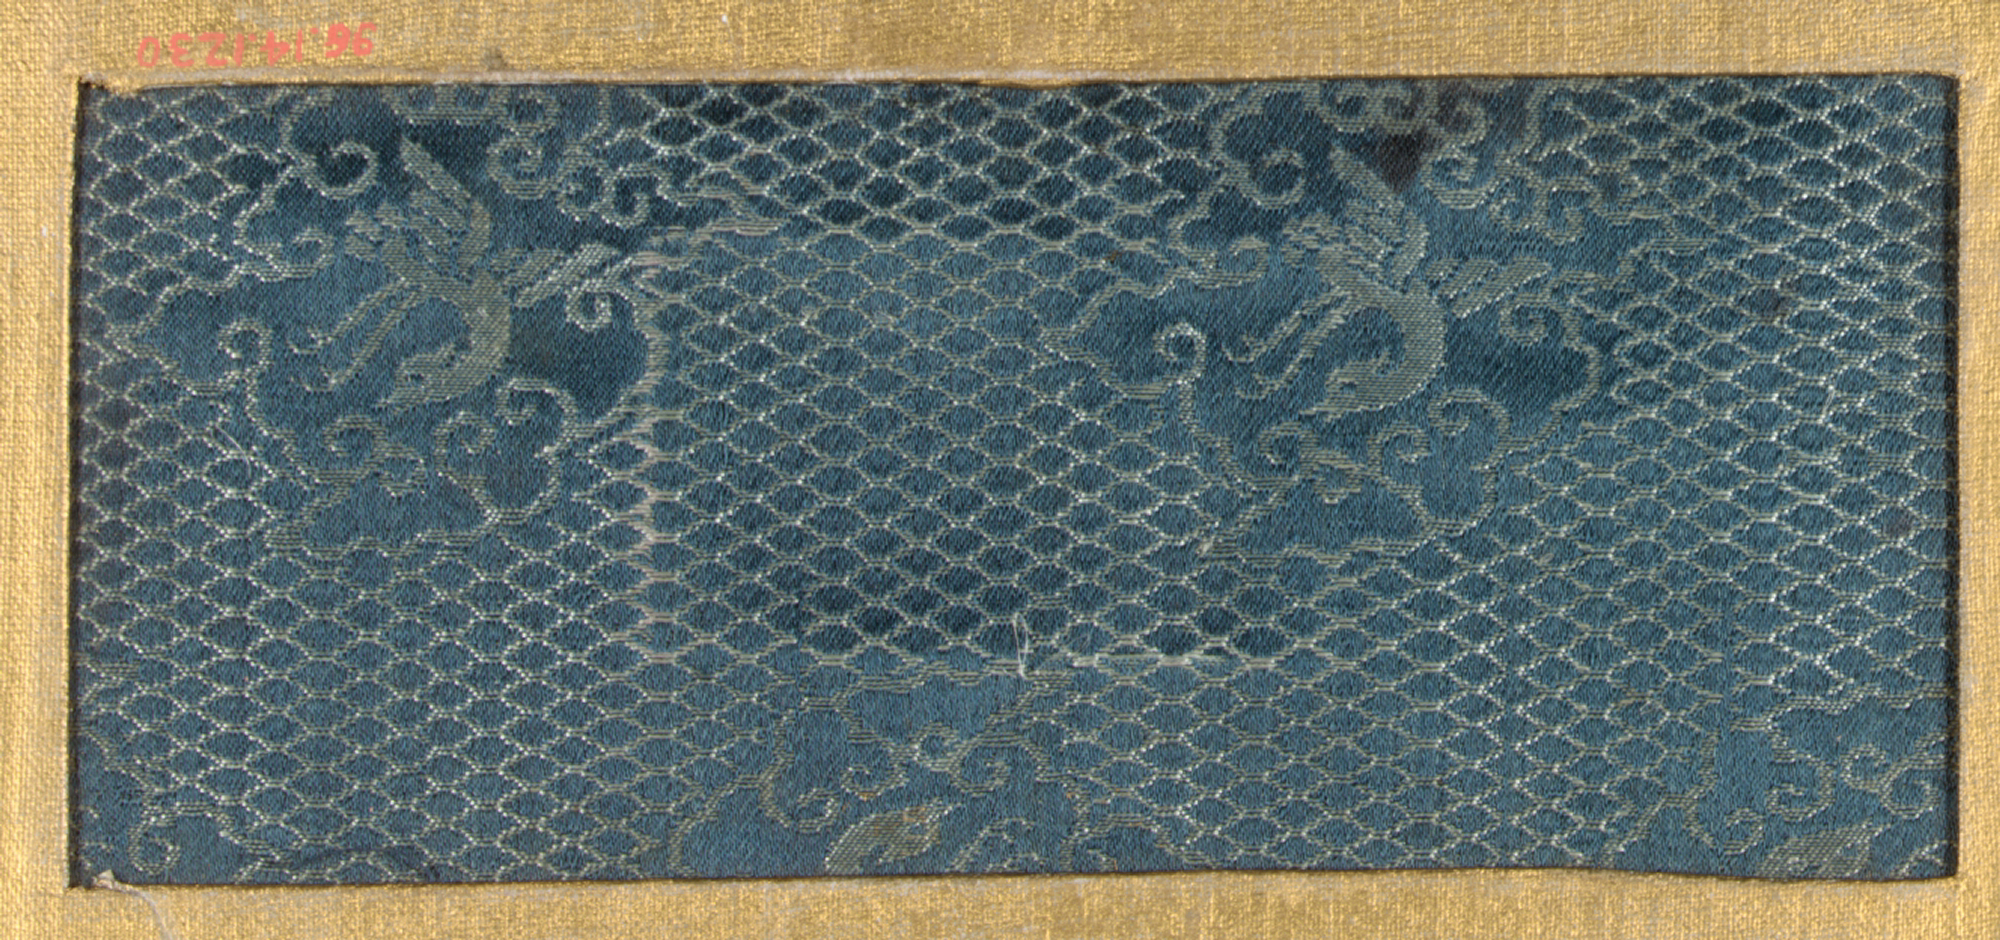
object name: piece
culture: japanese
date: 1701-1900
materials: silk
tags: birds